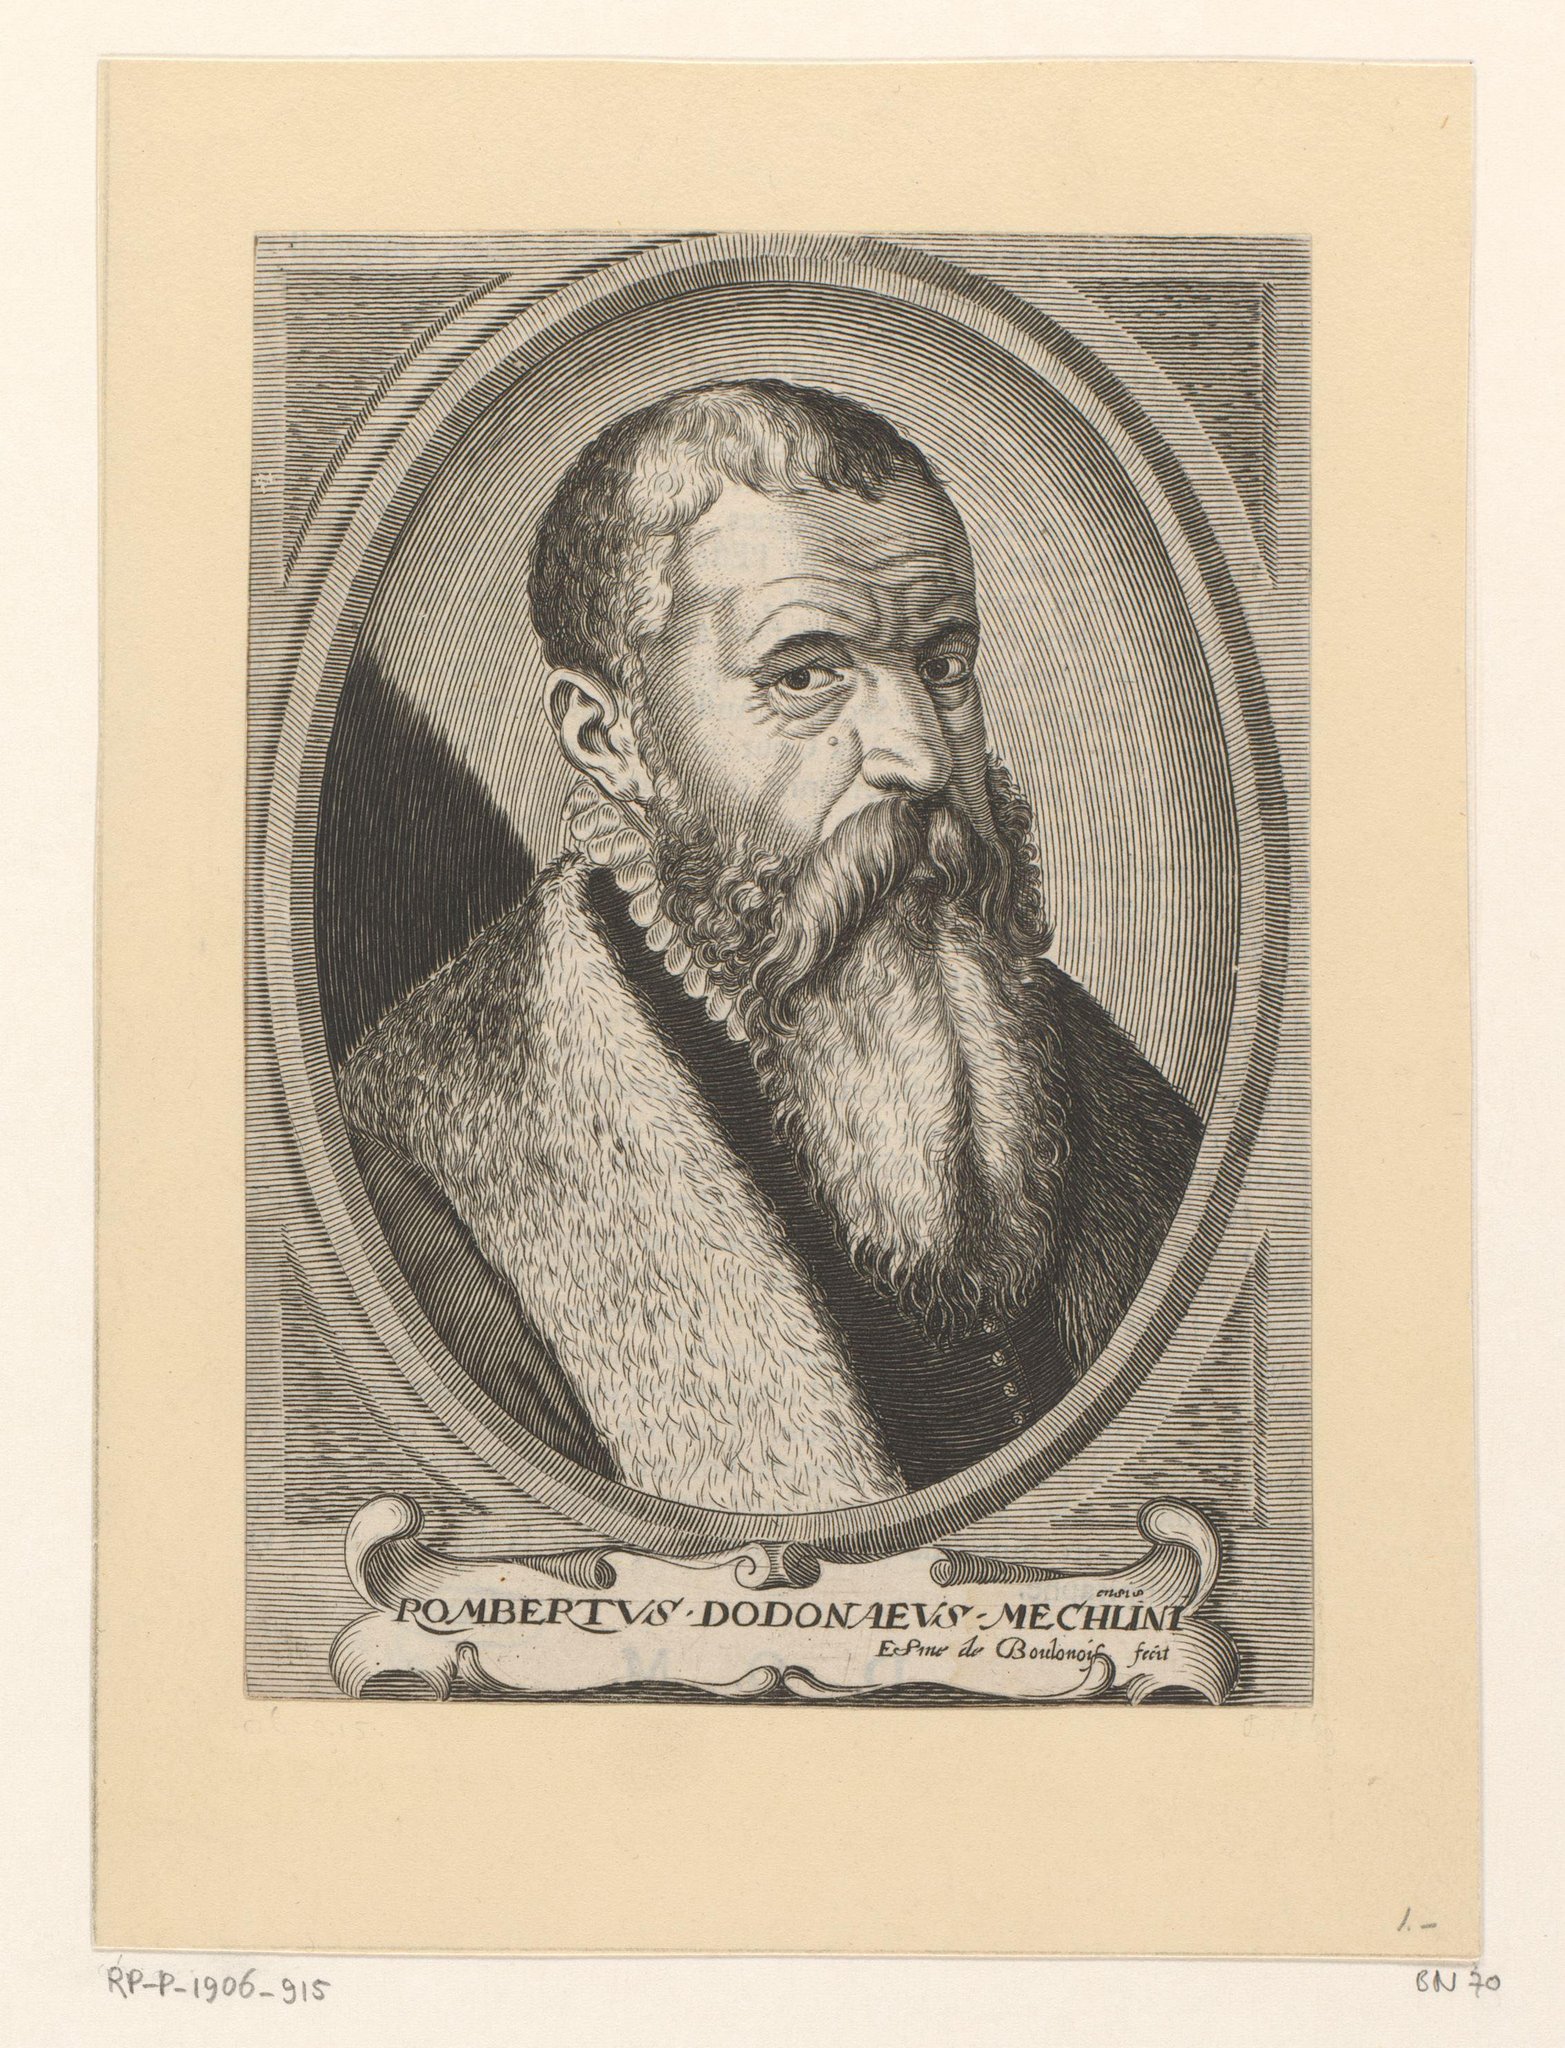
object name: print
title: Rombertus Dodonaeus Mechlini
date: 1682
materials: paper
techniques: engraving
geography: brussels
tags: mechelen, leiden, rembertus dodonaeus, historical persons, physician, doctor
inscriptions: collector's mark: Lugt 2228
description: Prent uit: Bullert, Isaac. Académie des Sciences et Arts contenant les vies et éloges his. des hommes illustres qui ont excellé en ces professions depuis environ quatre siècles. Brussel: Foppens, François, 1682. Het boek werd in 1682 eveneens in Amsterdam uitgegeven door de erfgenamen van Daniel Elzevier. Deze portretten dienen ter illustratie van de biografie van een kunstenaar of geleerde. De meeste portretten werden door Nicolas de Larmessin vervaardigd (162), 93 door De Boulonois en een derde door ongeïdentificeerde prentmakers. Dit betreft een illustratie op p. 99, deel II.